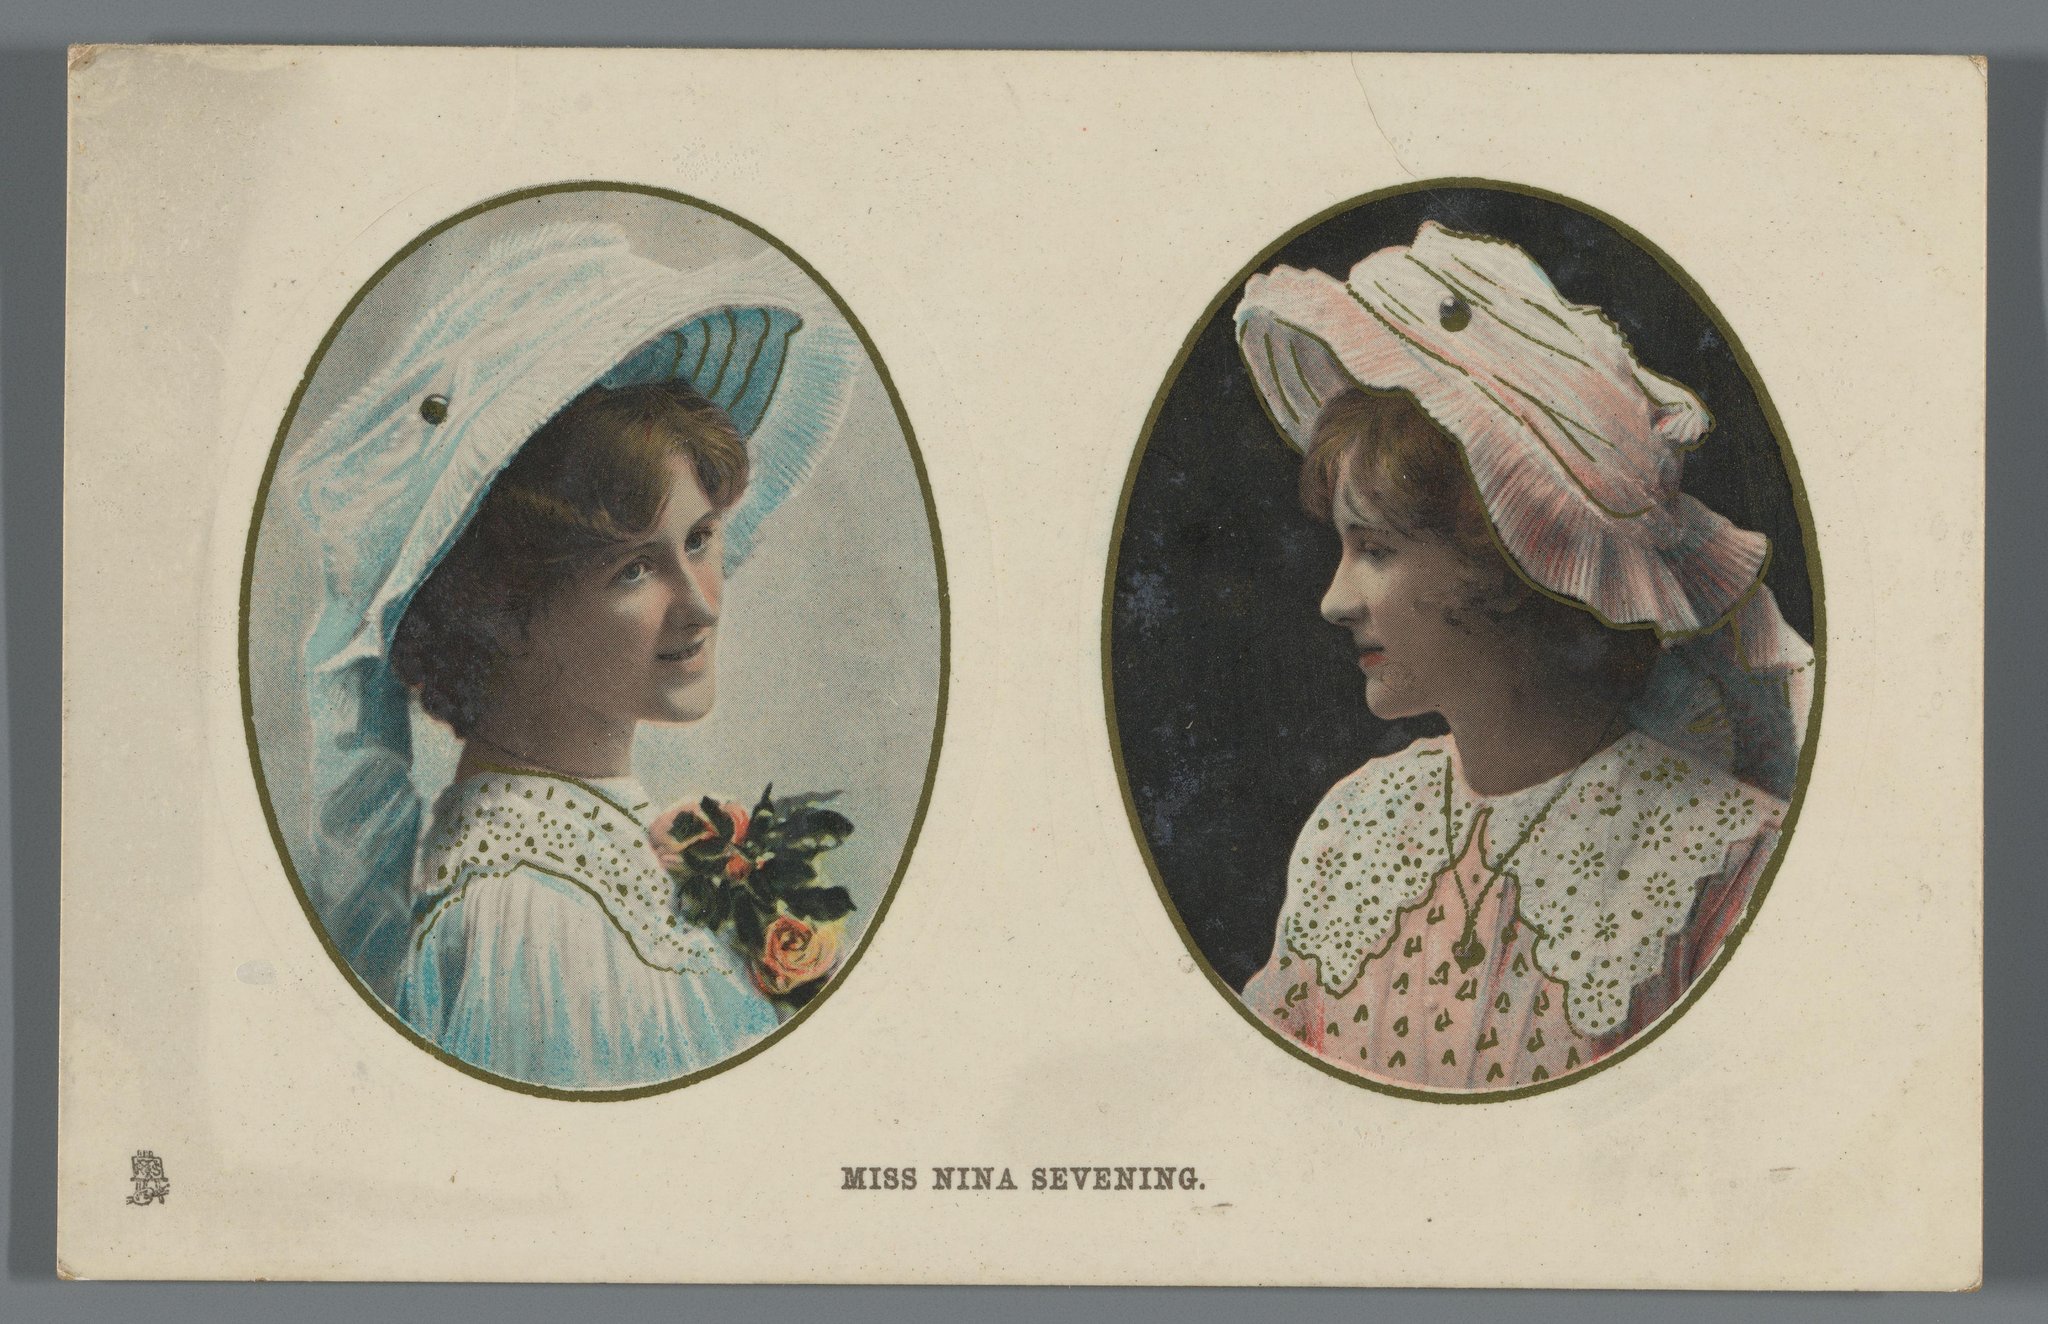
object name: ansichtkaart, prentbriefkaart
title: Miss Nina Sevening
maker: Anonymous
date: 1905-1914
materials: ink, paper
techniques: lithograph, pen, writing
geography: london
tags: portrait of actor, actress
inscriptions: inscription: ‘M/ varik [?]/ Anna van Aalst/ p/a Mevrouw de Wed. Silevis/ Kerk-Avezaaht’